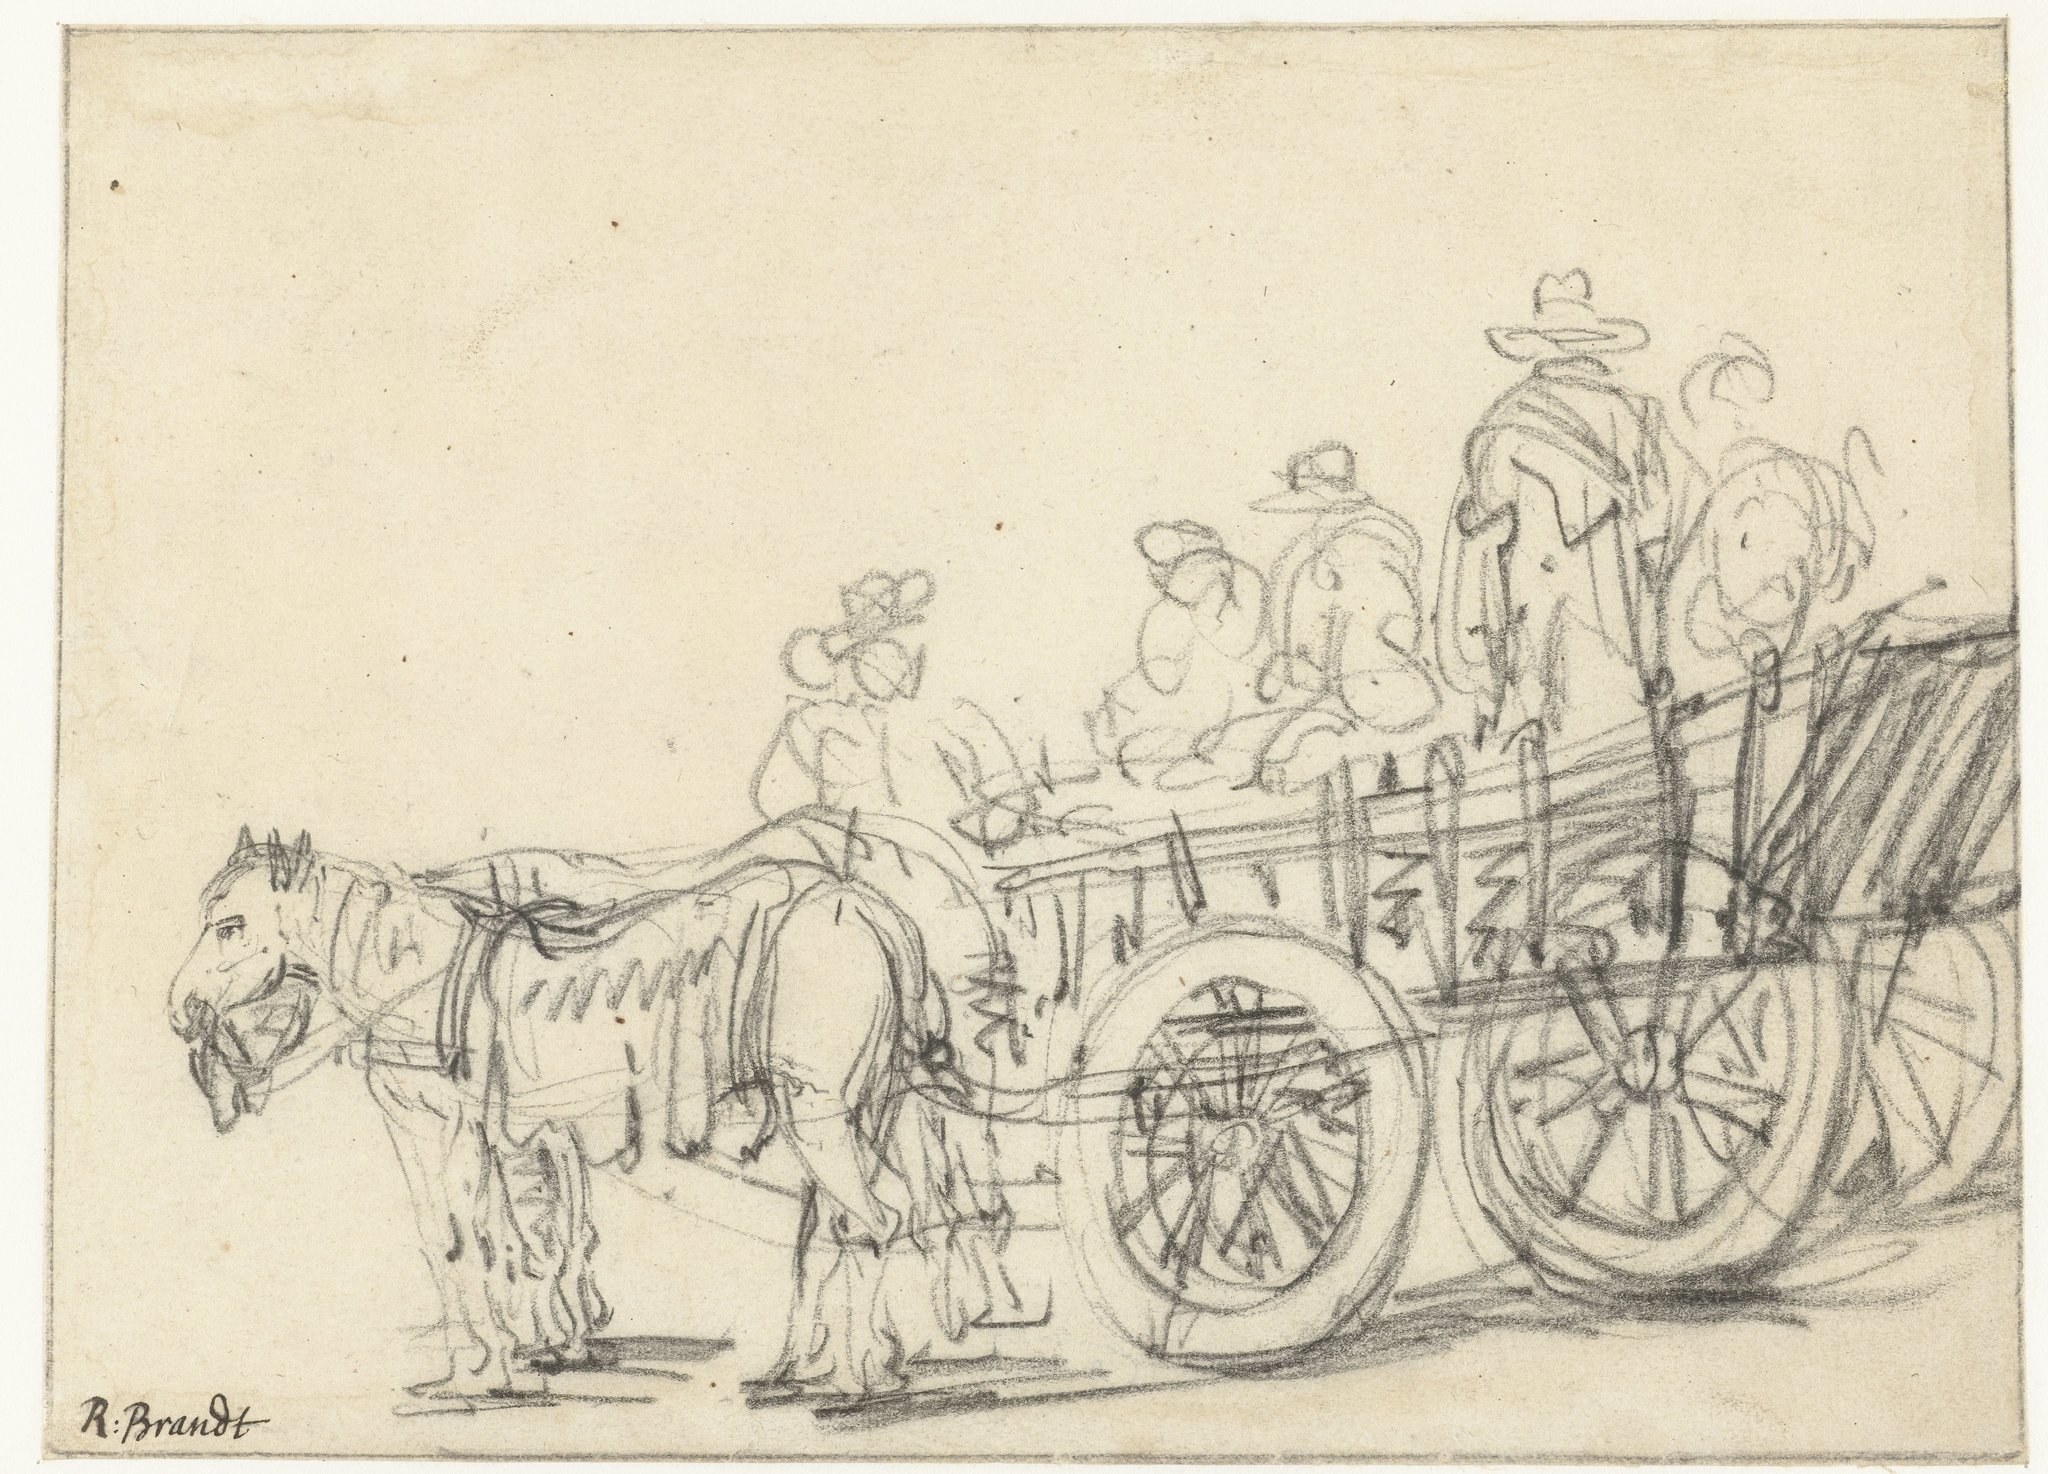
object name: drawing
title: Stilstaande boerenwagen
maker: Anonymous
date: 1600-1699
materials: chalk, paper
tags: (farm) wagon, freight wagon, cart